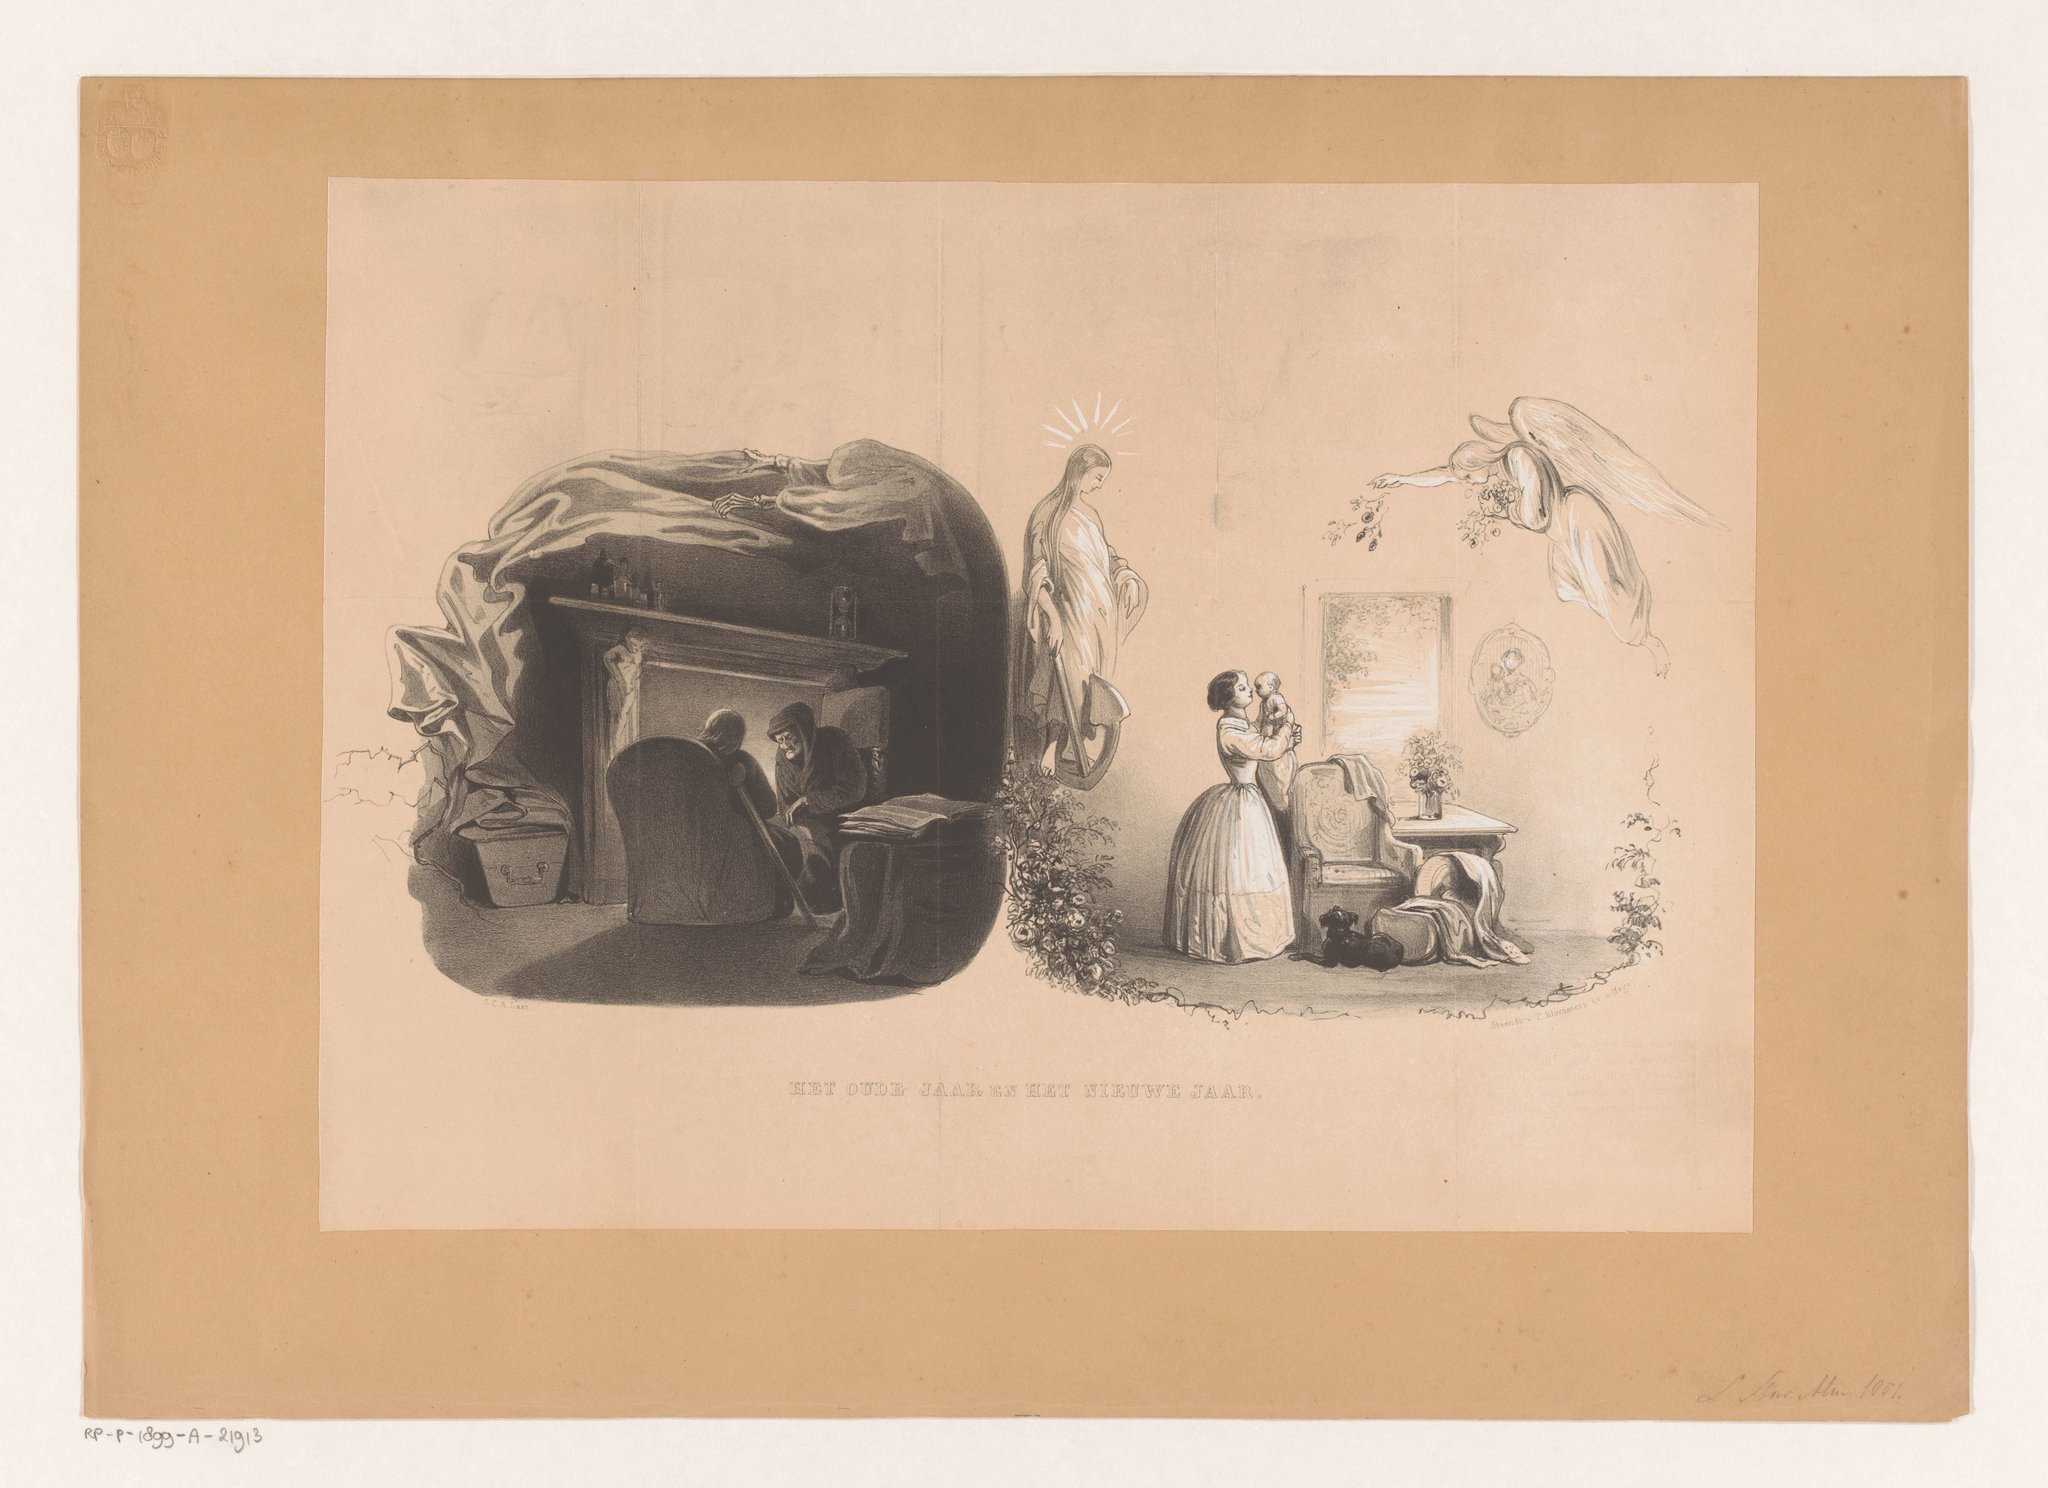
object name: print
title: Het oude jaar en het nieuwe jaar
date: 1818-1876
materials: paper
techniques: tone lithography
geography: the hague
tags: old age, 'senectus'; 'vecchiezza' (ripa), lunar year, open hearth, fire-place, mother and baby or young child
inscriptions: collector's mark: Lugt 2228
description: De oude mensen zitten bij een open haard. De moeder houdt het kind omhoog.